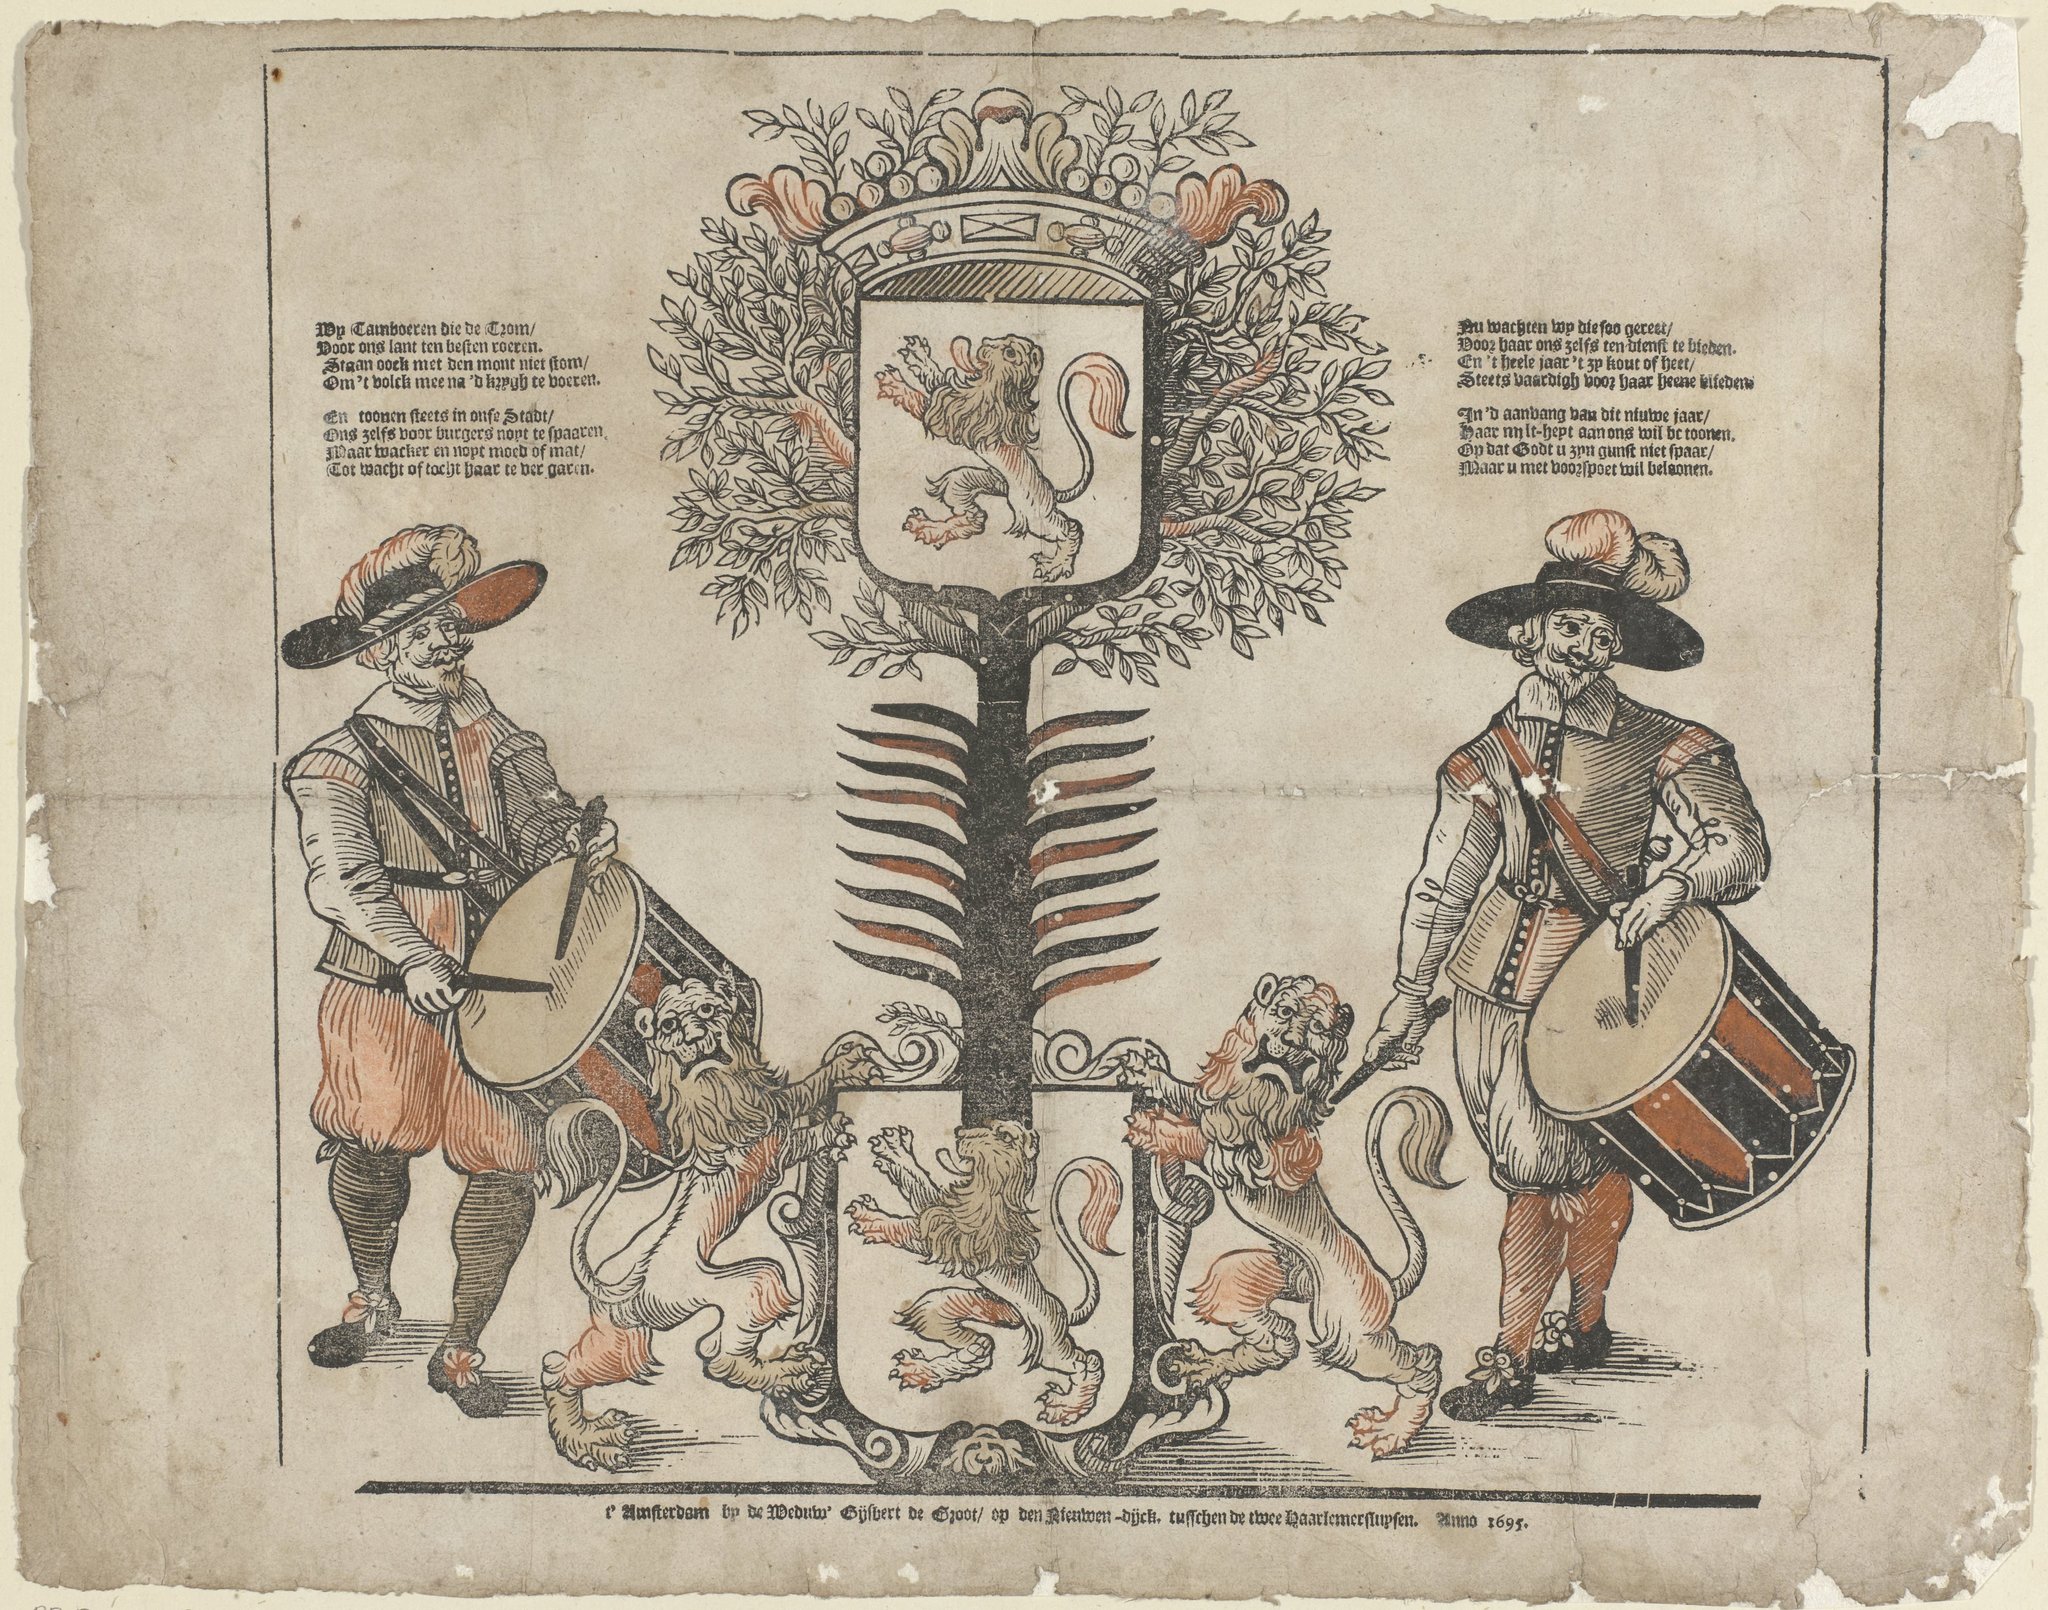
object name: print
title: Boom met twee wapenschilden, aan elke zijde een tamboer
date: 1695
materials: paper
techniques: colour, letterpress printing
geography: amsterdam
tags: coat of arms (as symbol of the state, etc.), trees, drum (musical instrument)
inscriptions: collector's mark: Lugt 2228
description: Boom met twee wapenschilden, één bij de wortels en één in de kruin. Aan weerszijden van de boom een leeuw en een tamboer. Voorstelling in een kader. Boven de tamboers twee achtregelige verzen.